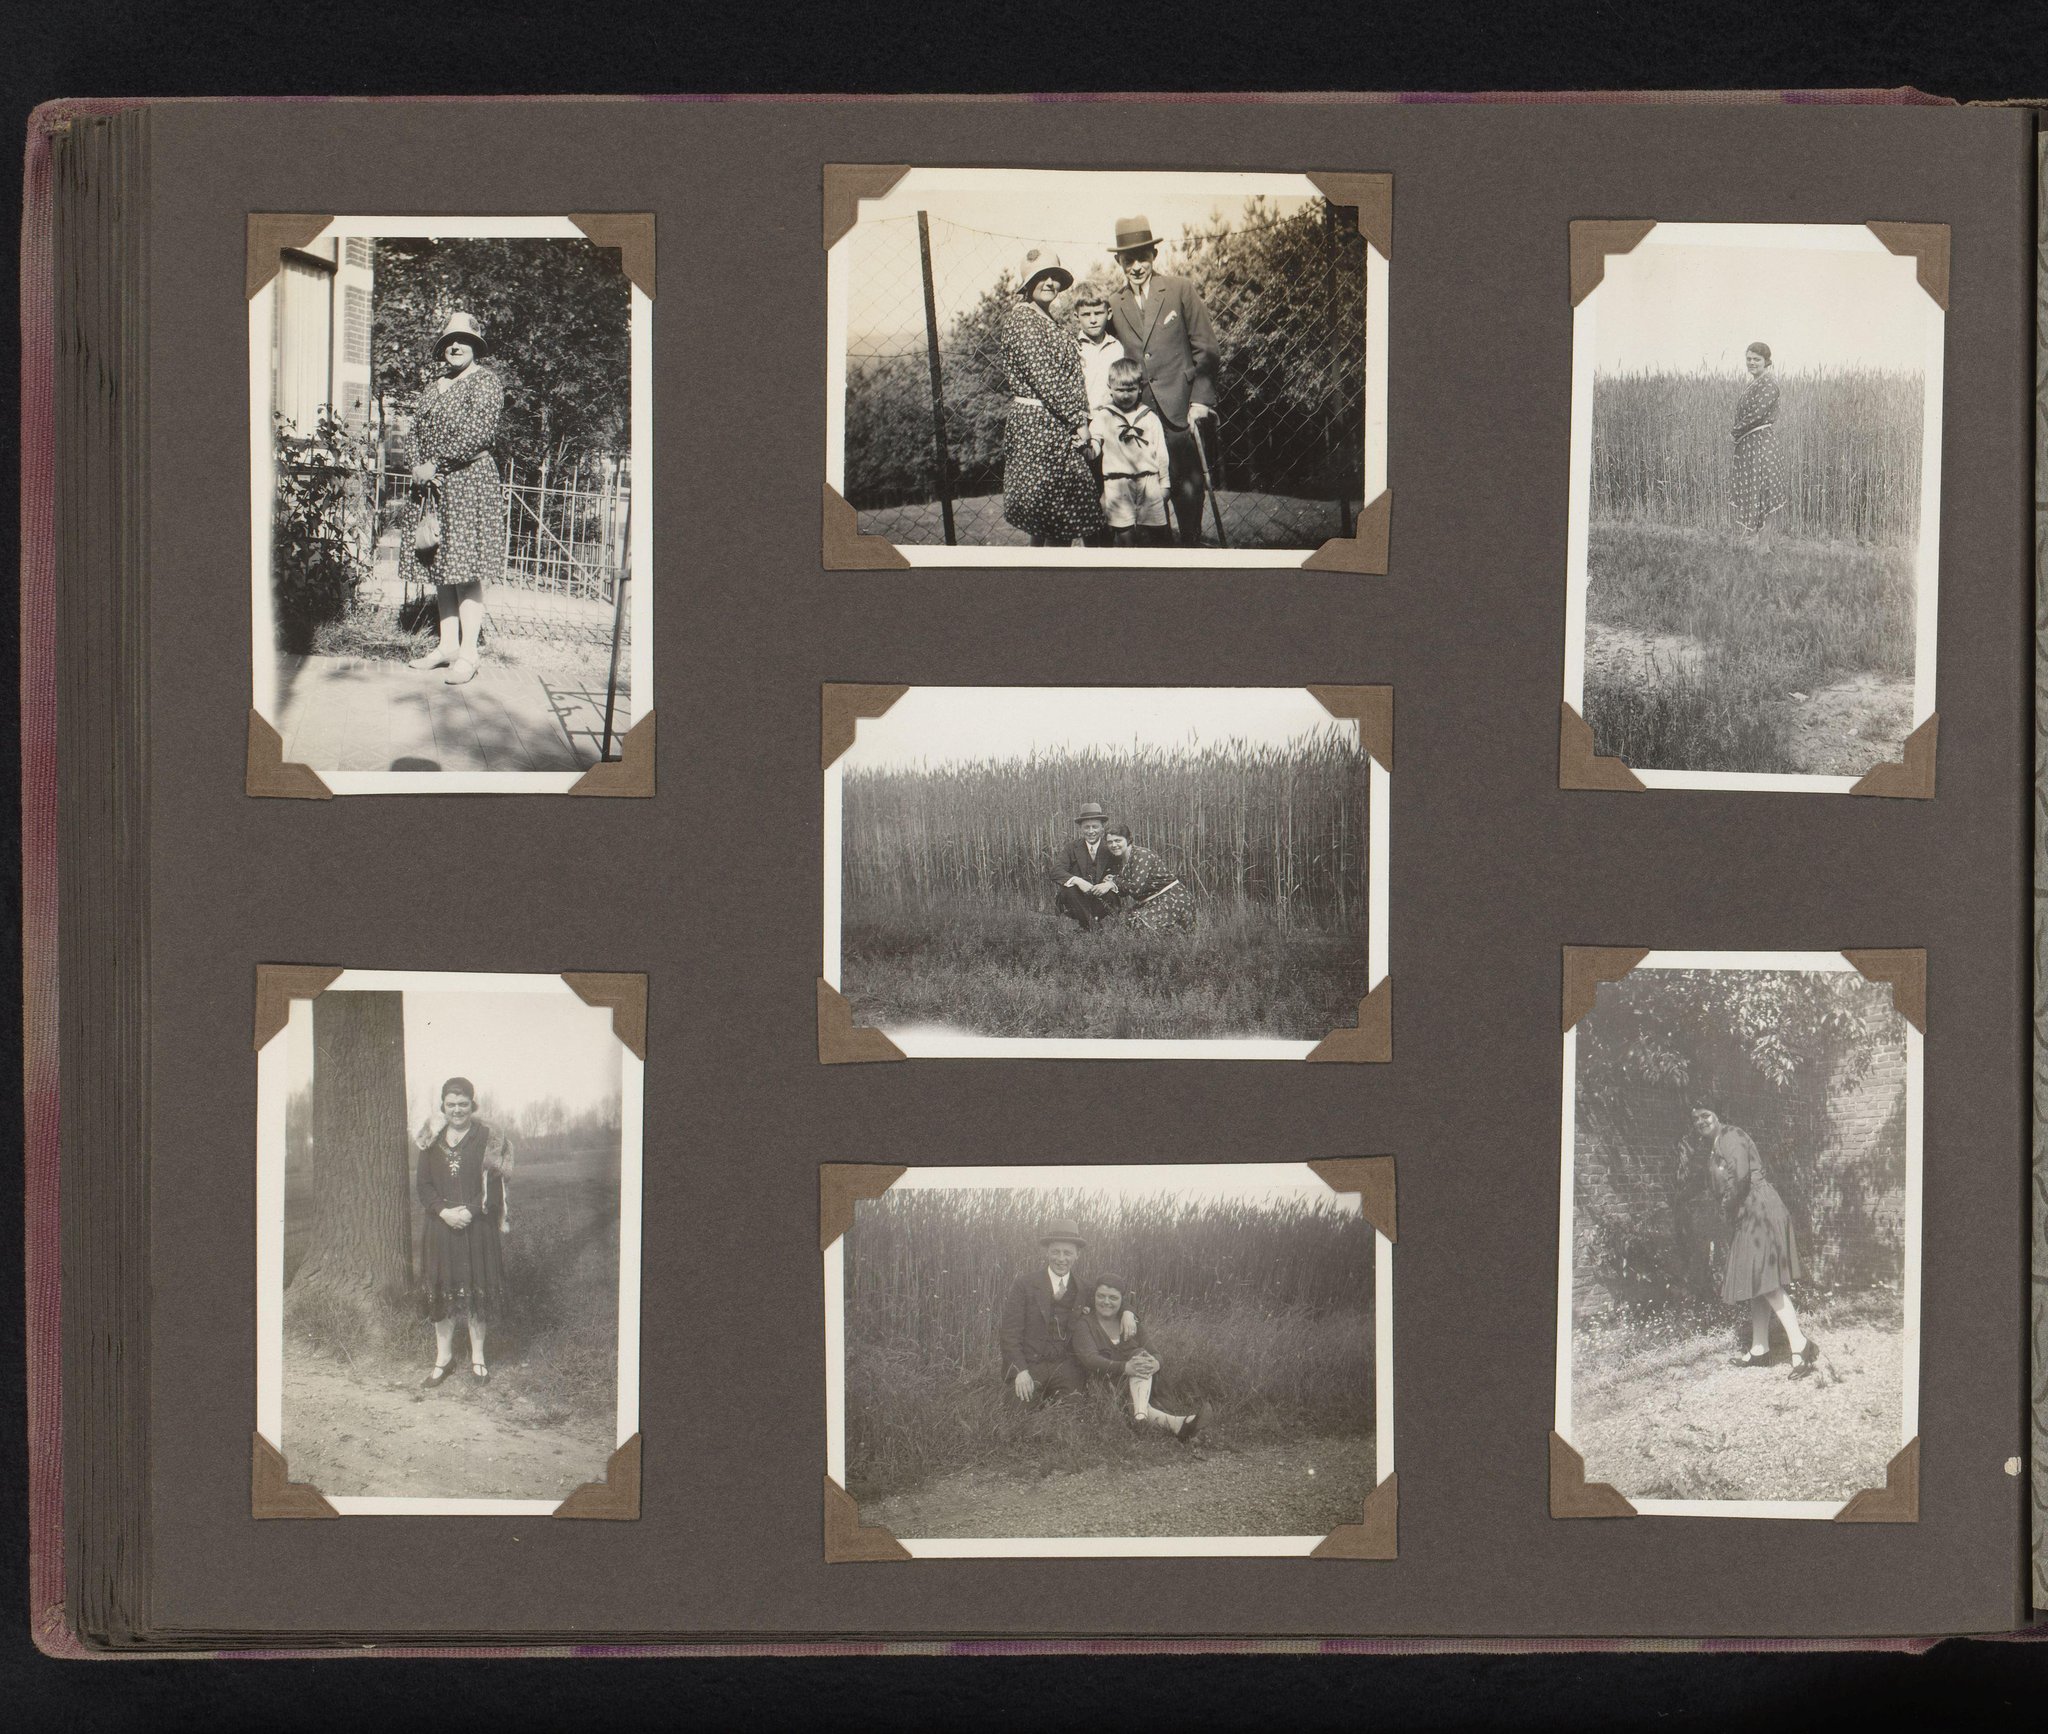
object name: photograph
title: Zeven portretten van kennissen van Herman Besselaar en Berti Hoppe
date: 1930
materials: cardboard, photographic support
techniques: gelatin silver print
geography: netherlands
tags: historical persons - bb - woman, anonymous historical persons portrayed in a group, in a group-portrait, netherlands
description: Vier portretten van de vrouw, twee portretten van het echtpaar en een portret van het gezin. Deze foto's maken deel uit van een album.